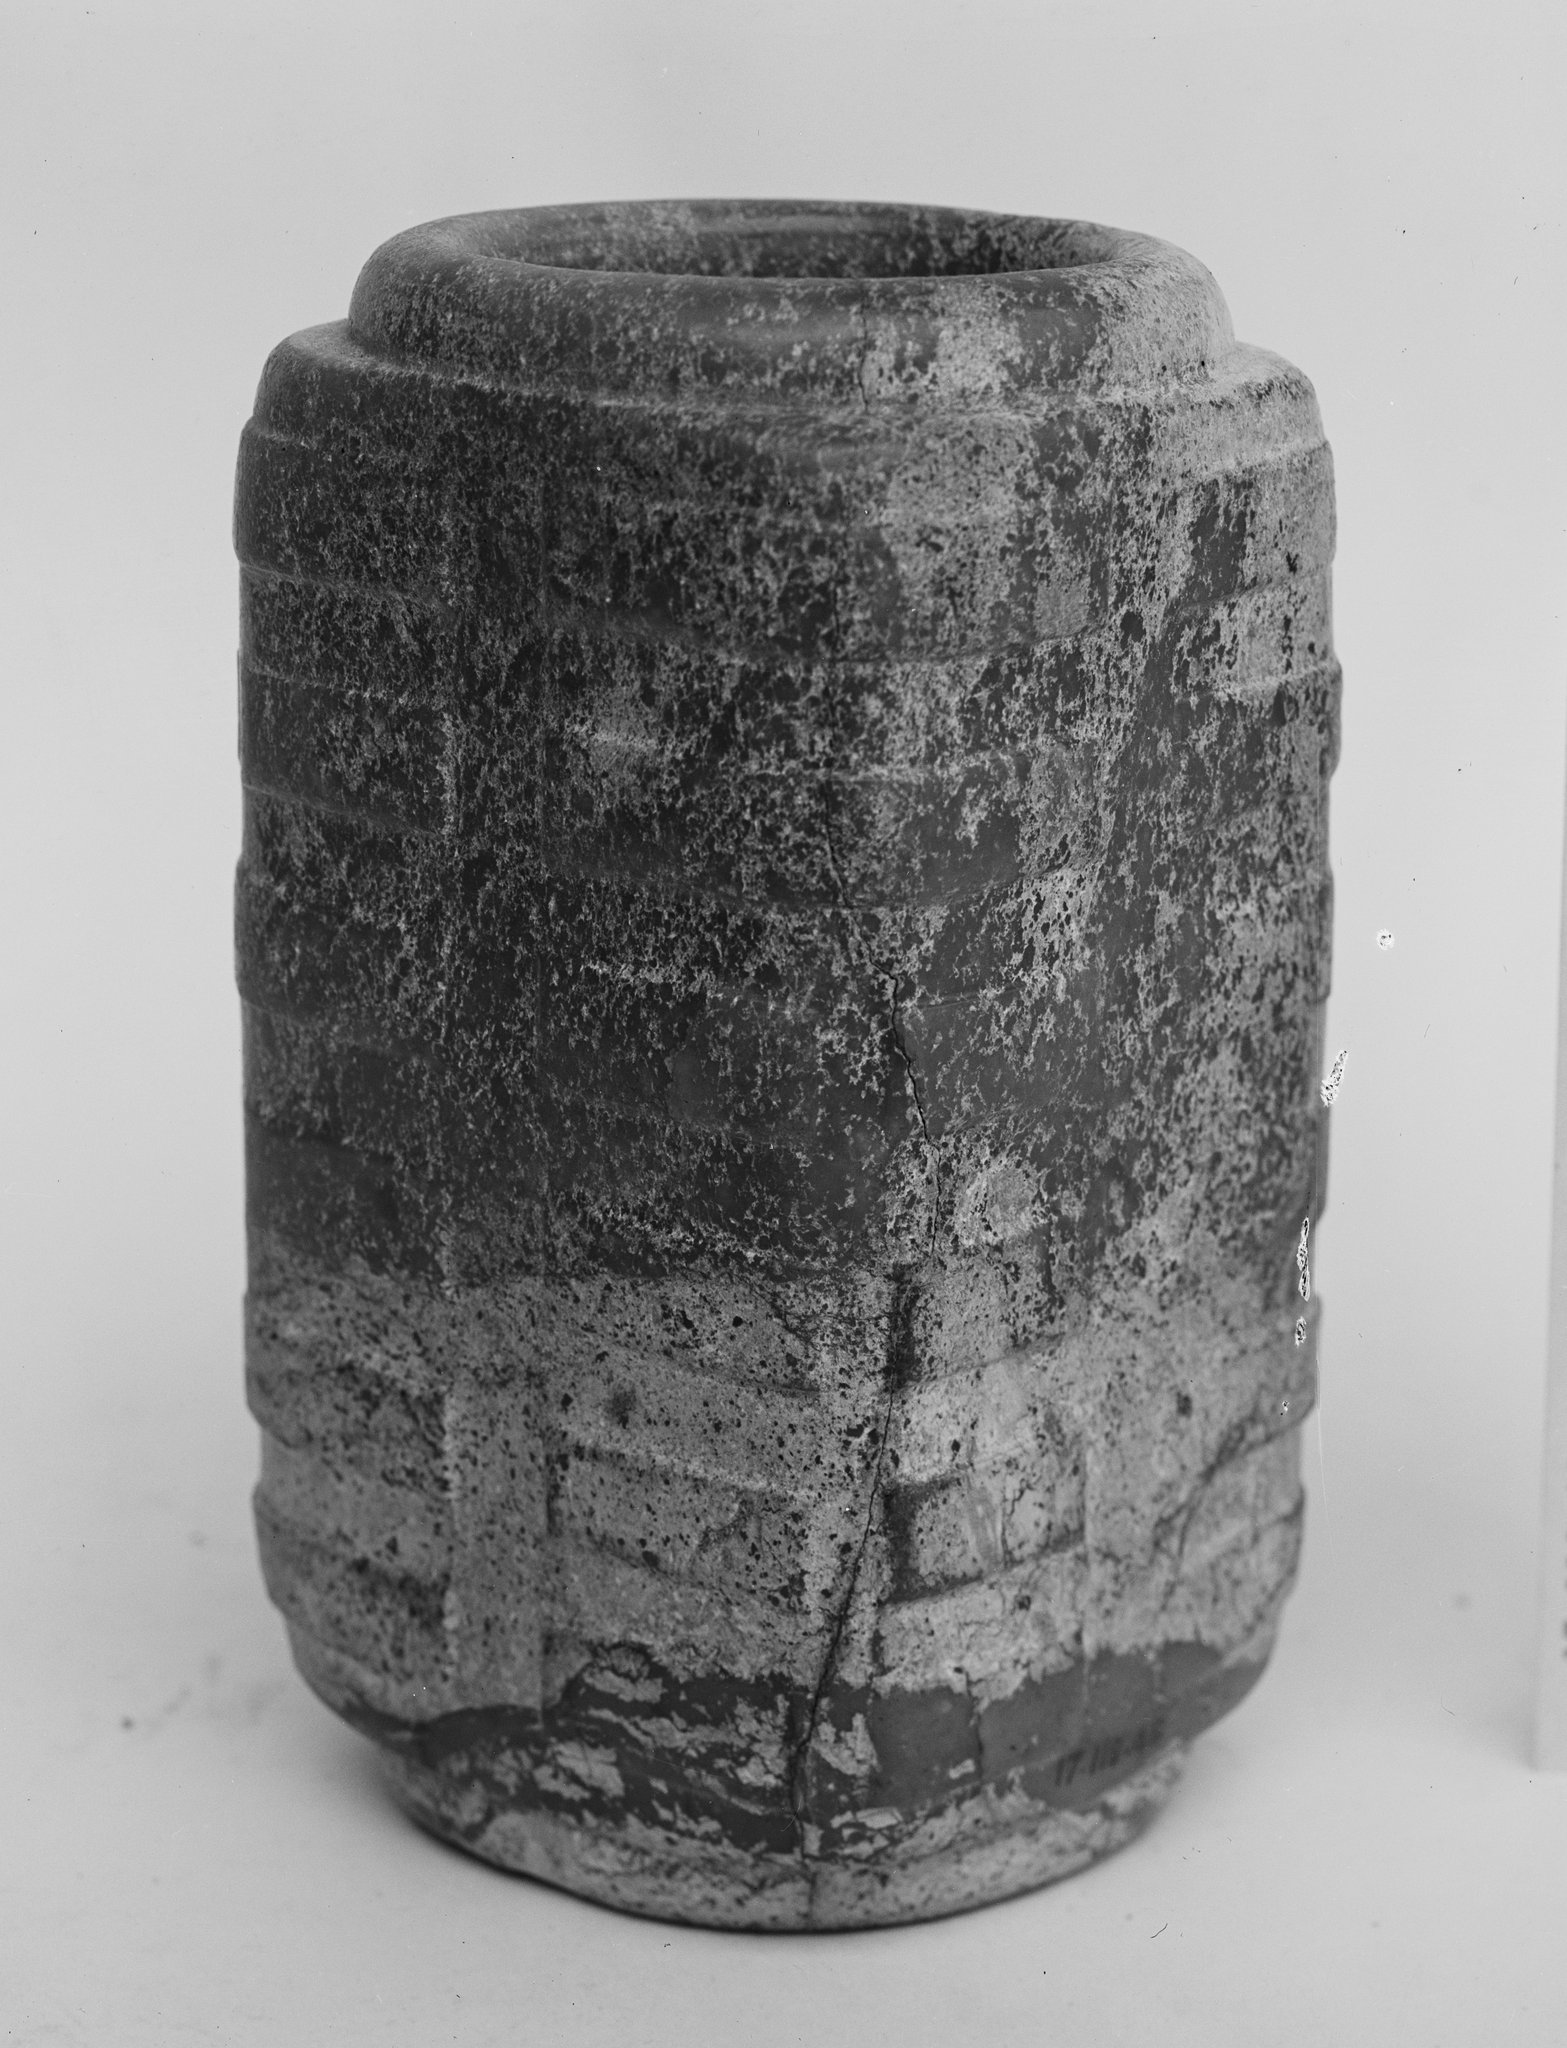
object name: religious ritual object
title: Ritual object (Cong)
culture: chinese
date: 1801-1900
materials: jade